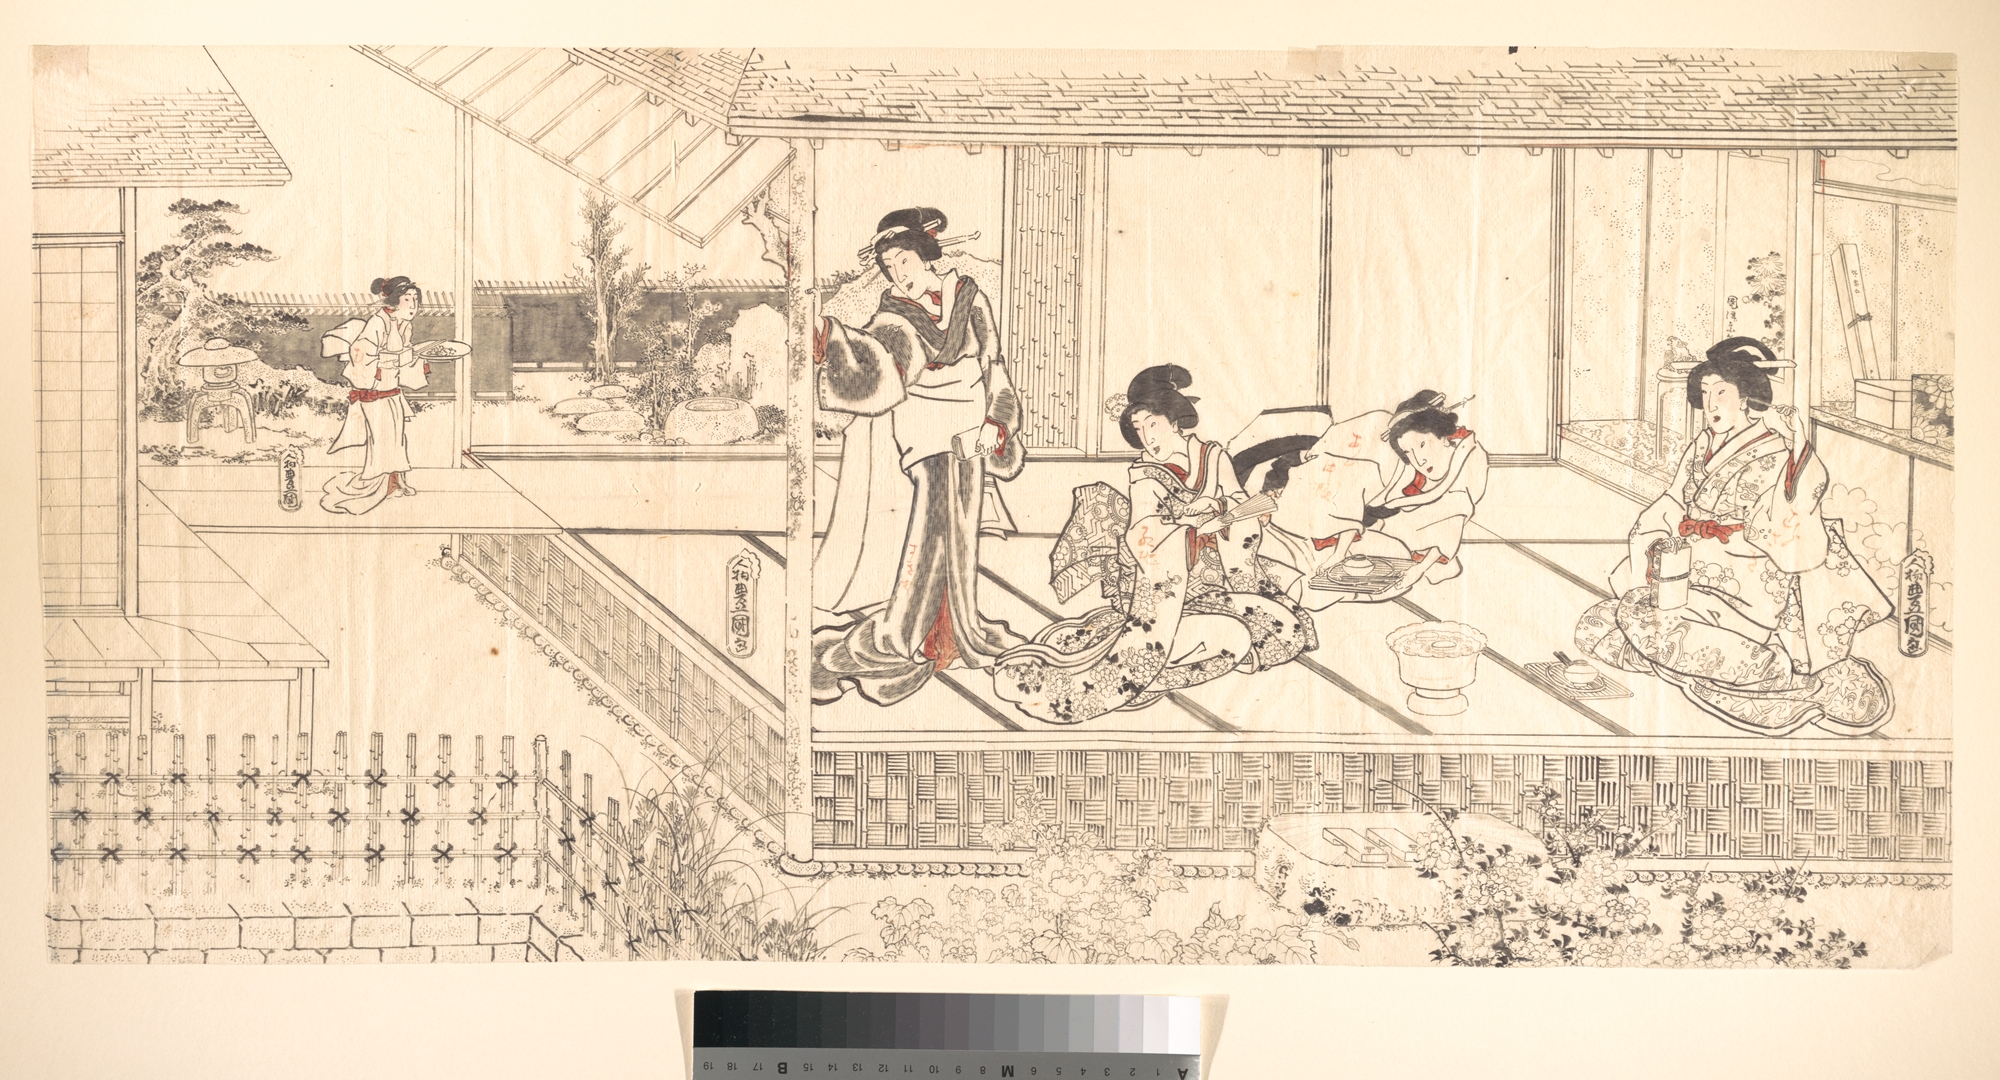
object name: print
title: Two Court Ladies (Goten Jochu) and a Geisha at a Restaurant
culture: japanese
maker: utagawa kunisada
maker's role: artist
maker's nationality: japanese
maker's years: 1786-1864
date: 1844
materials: ink, paper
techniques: woodblock print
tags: restaurants,interiors,women